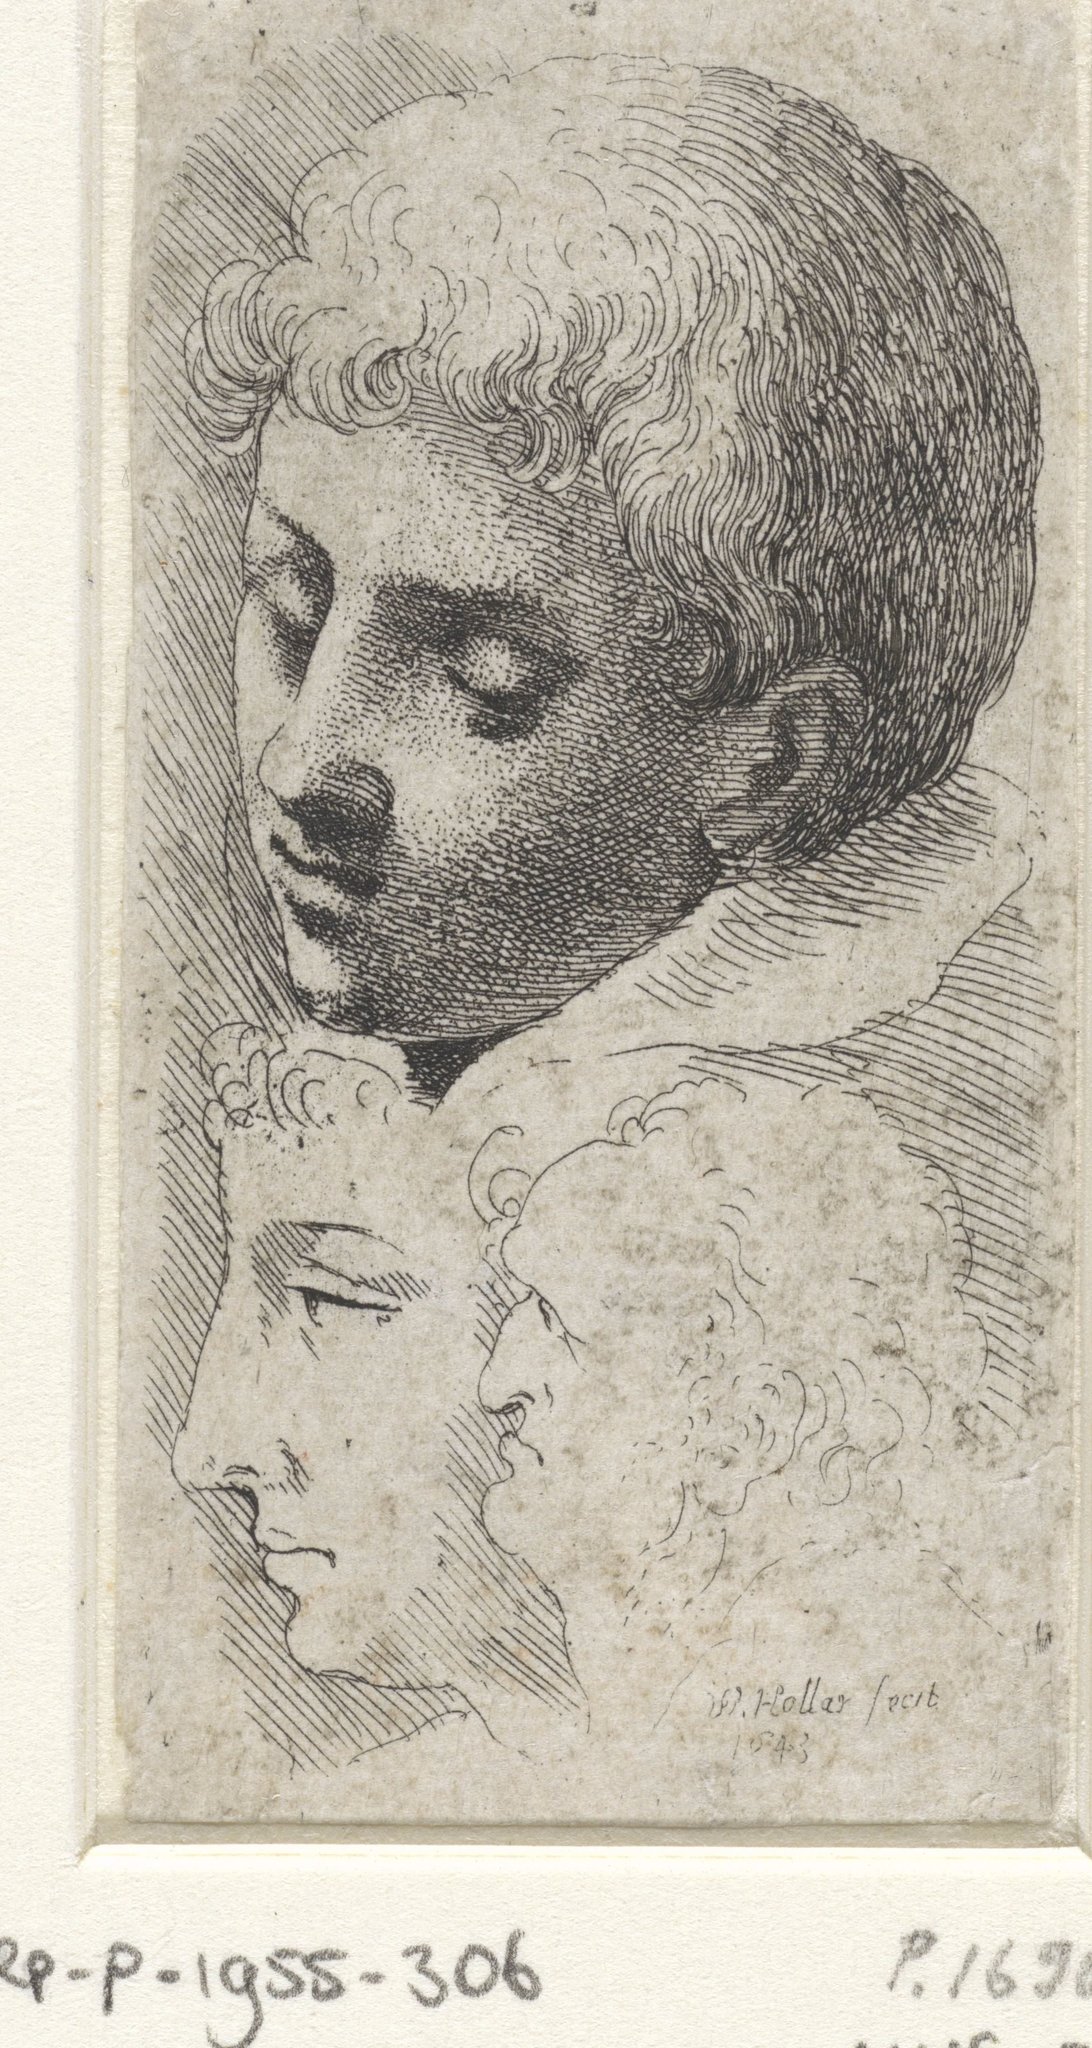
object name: print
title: Hoofd van een jongen en twee profielen van mannen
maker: wenceslaus hollar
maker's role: draughtsman, print maker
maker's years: 1607-1677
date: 1645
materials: paper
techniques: etching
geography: antwerp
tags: head (human)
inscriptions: date